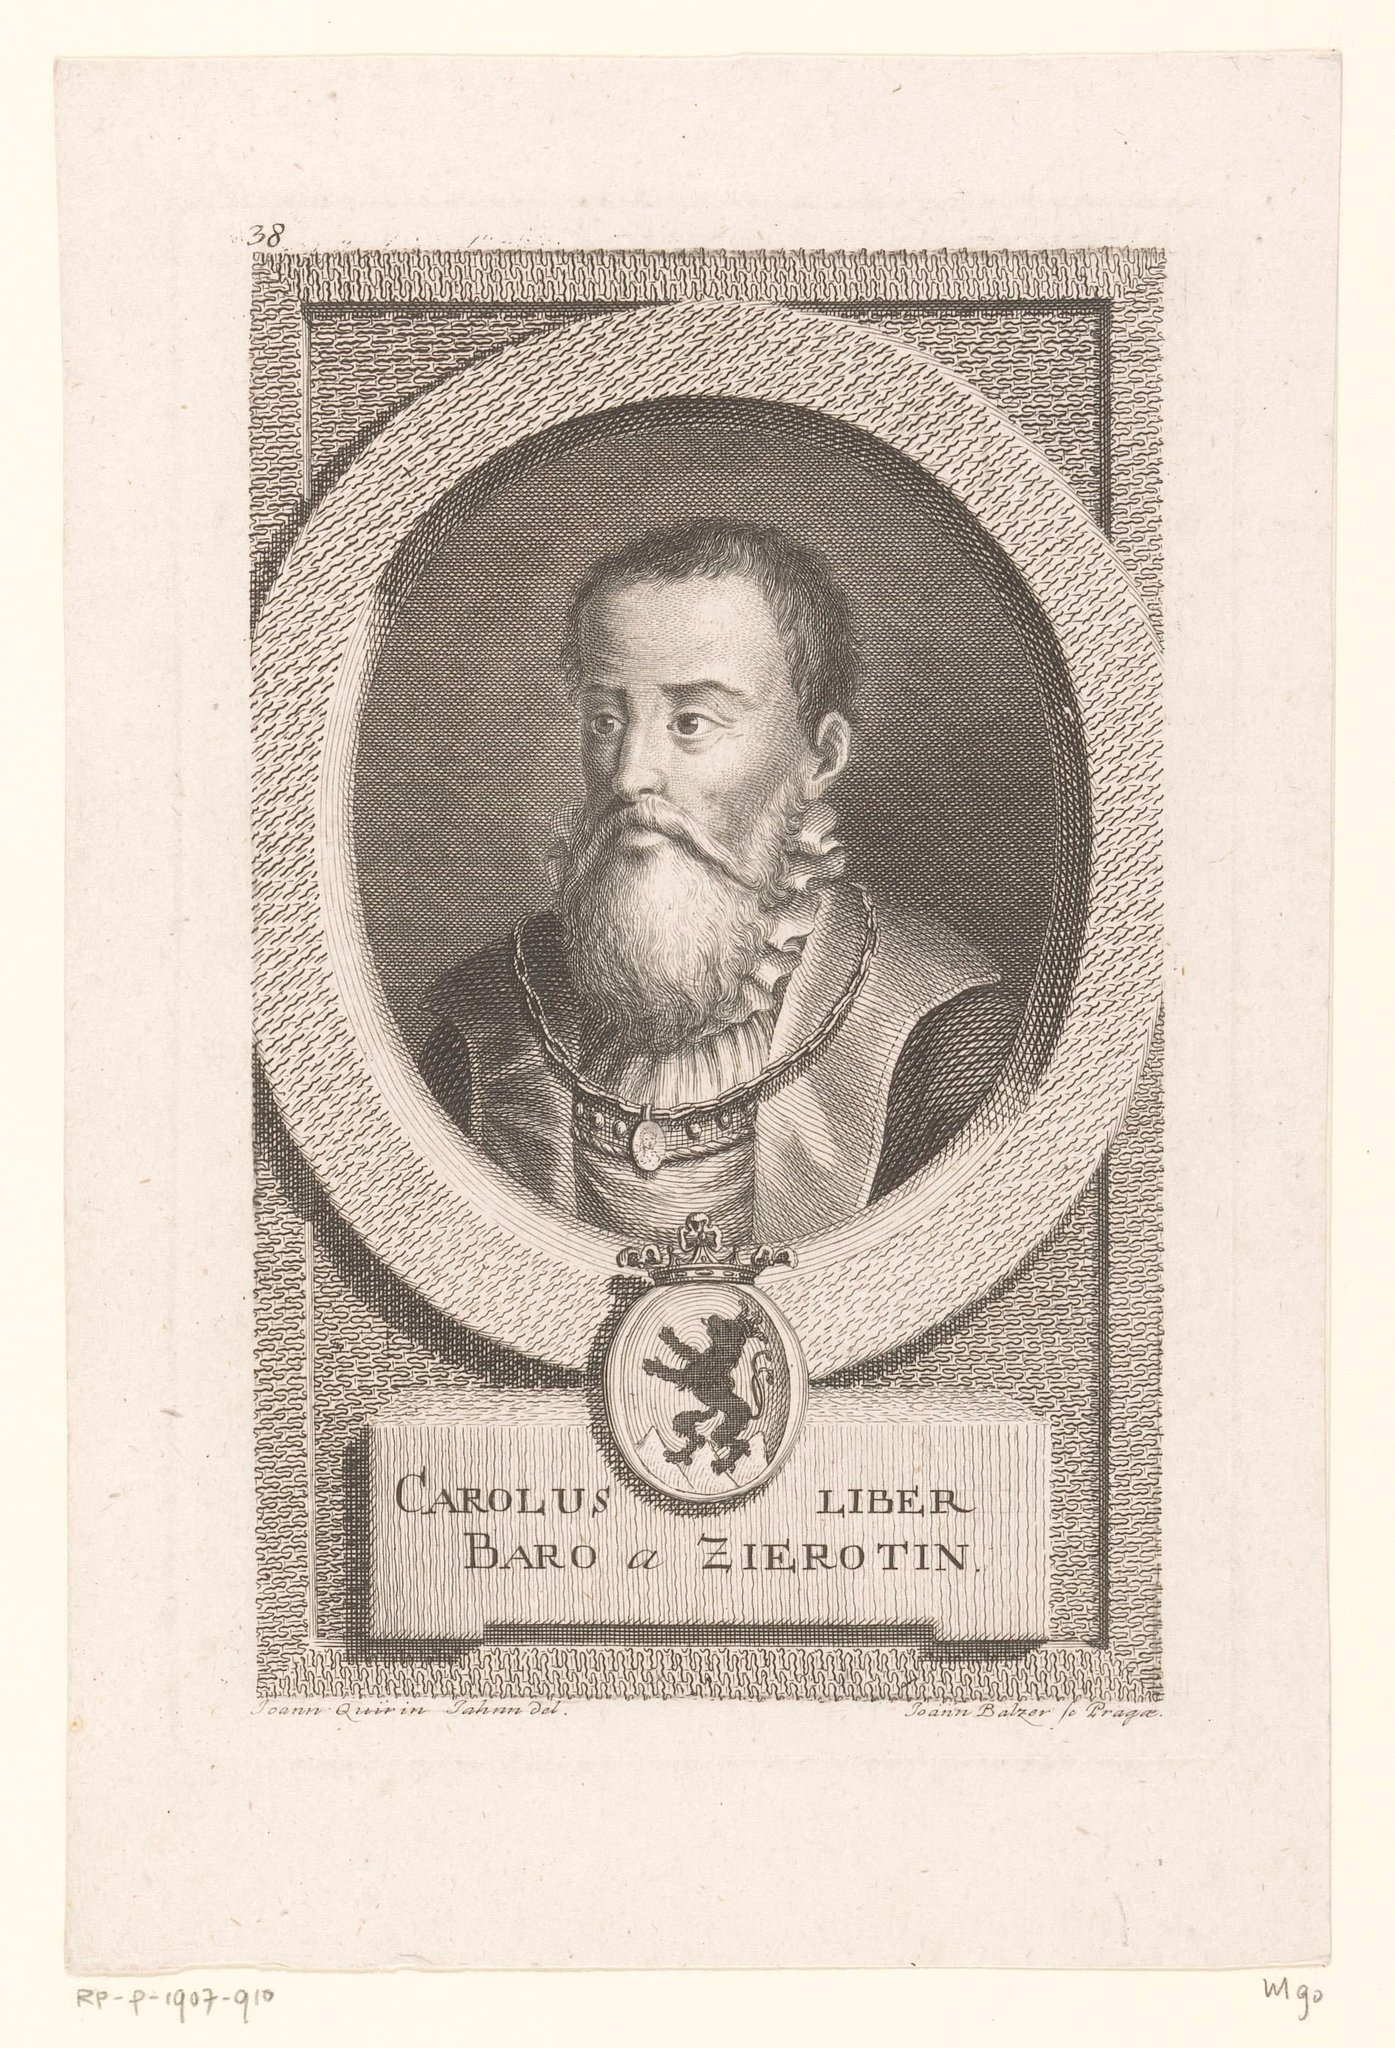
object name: print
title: Carolus Liber Baro a Zierotin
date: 1749-1799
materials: paper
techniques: engraving, etching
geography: prague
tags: historical persons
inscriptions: collector's mark: Lugt 2228